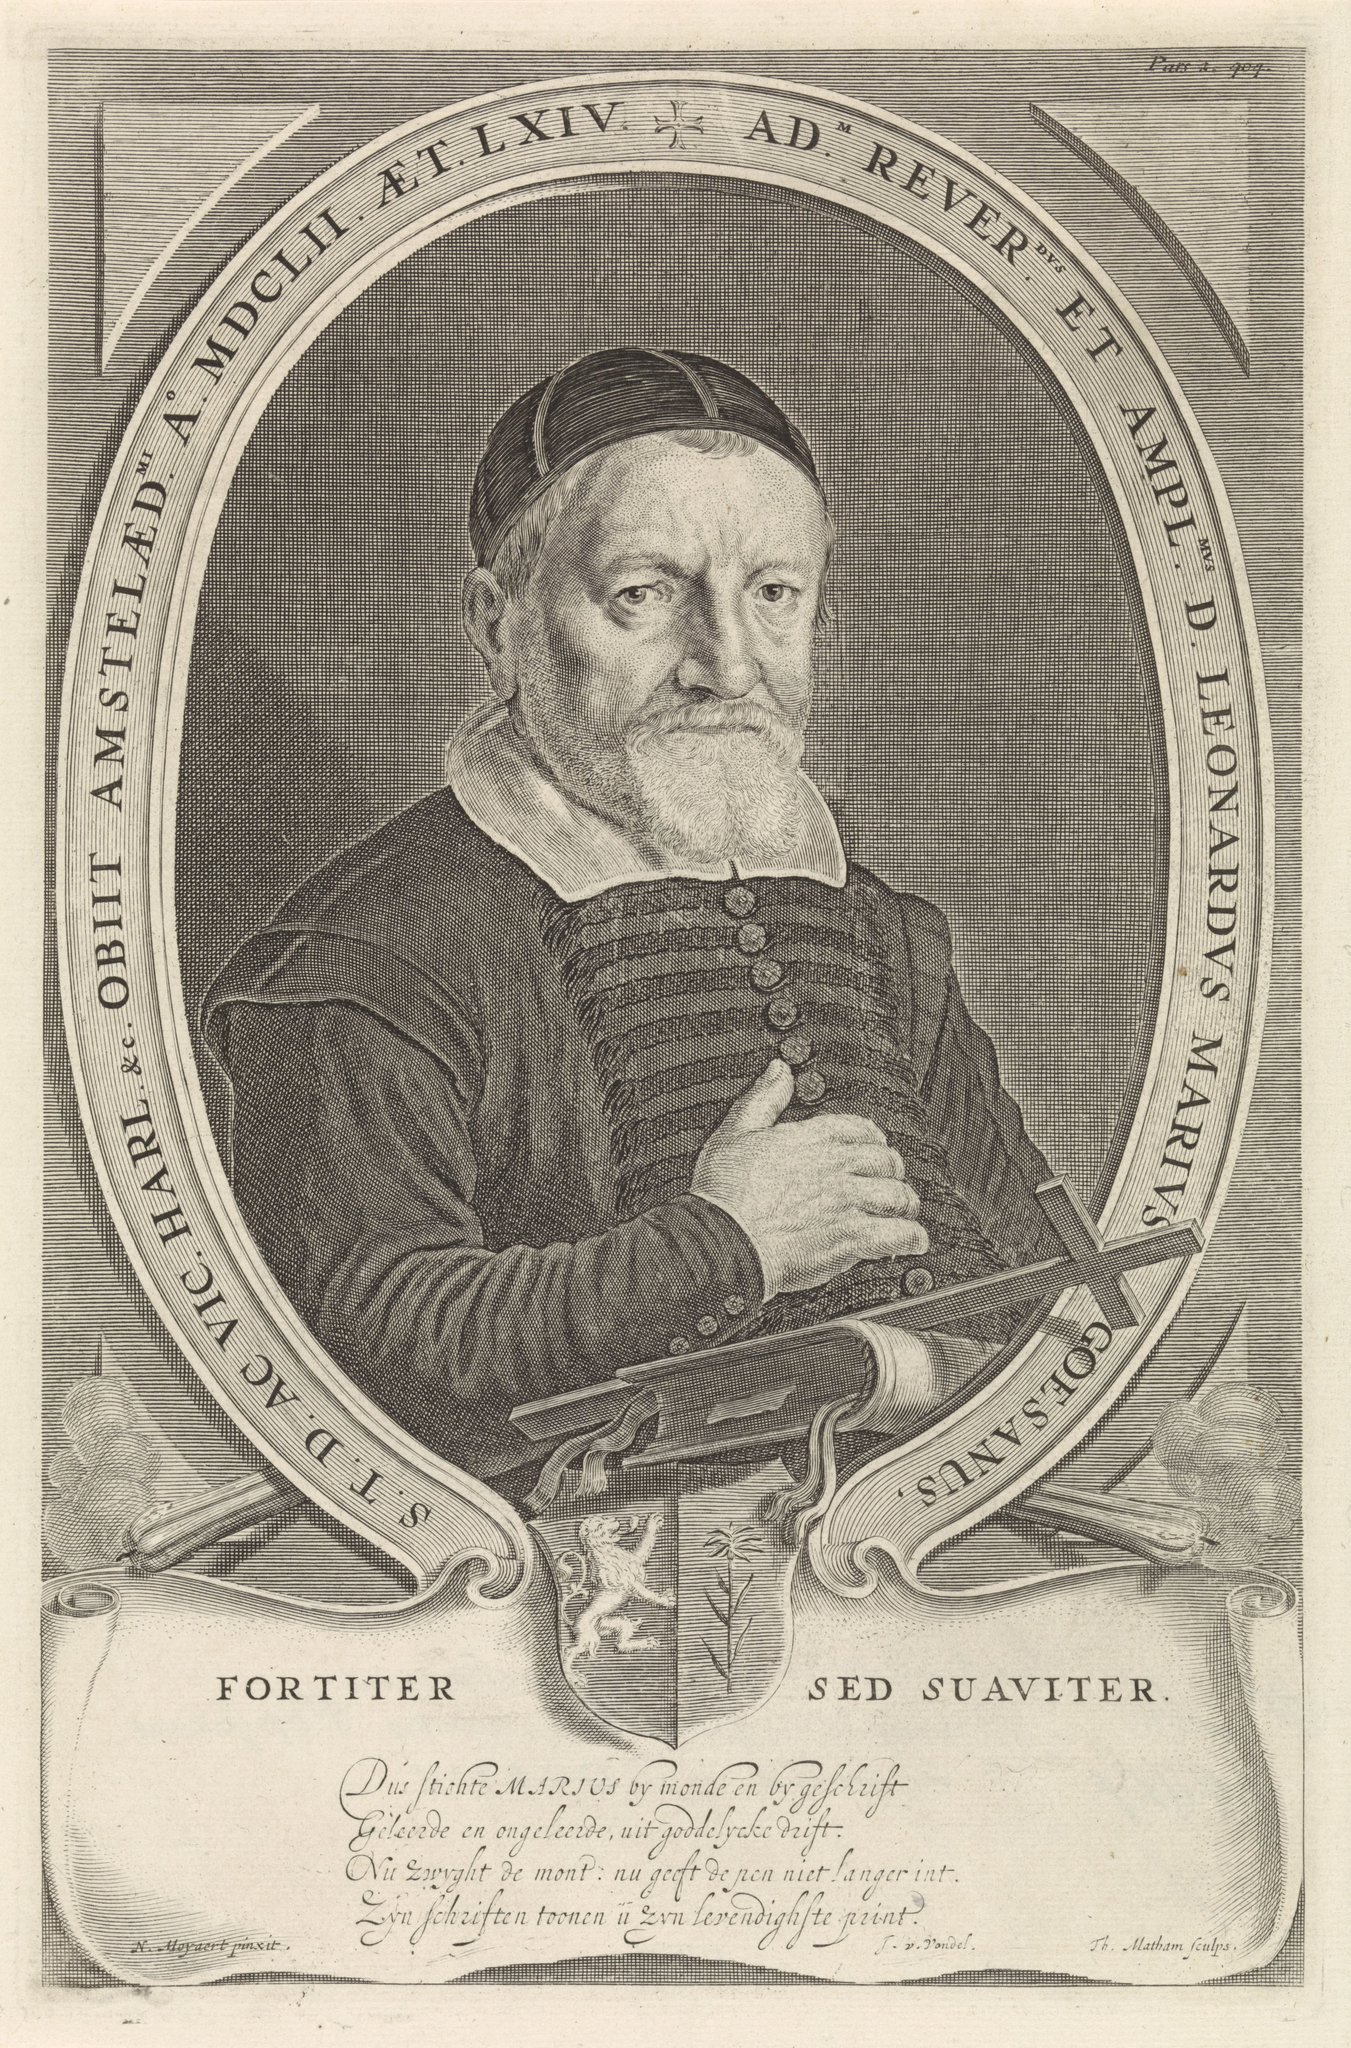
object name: print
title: Portret van Leonard Marius van der Goes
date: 1652-1676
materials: paper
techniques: engraving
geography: brussels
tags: priest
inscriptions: inscription: ‘behoort in Batavia Sacra/ Bruxelles pro Francisco Foppens/ in folio MDCCXIV’, collector's mark: Lugt 2228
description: Volgens opschrift op het verso prent gebruikt als boekillustratie in: Heussen, H.F. van. Batavia sacra, sive Res gestæ apostolicorum virorum, qui fidem Bataviæ primi intulerunt. 2 dln. Brussel: Franciscus Foppens, 1714.